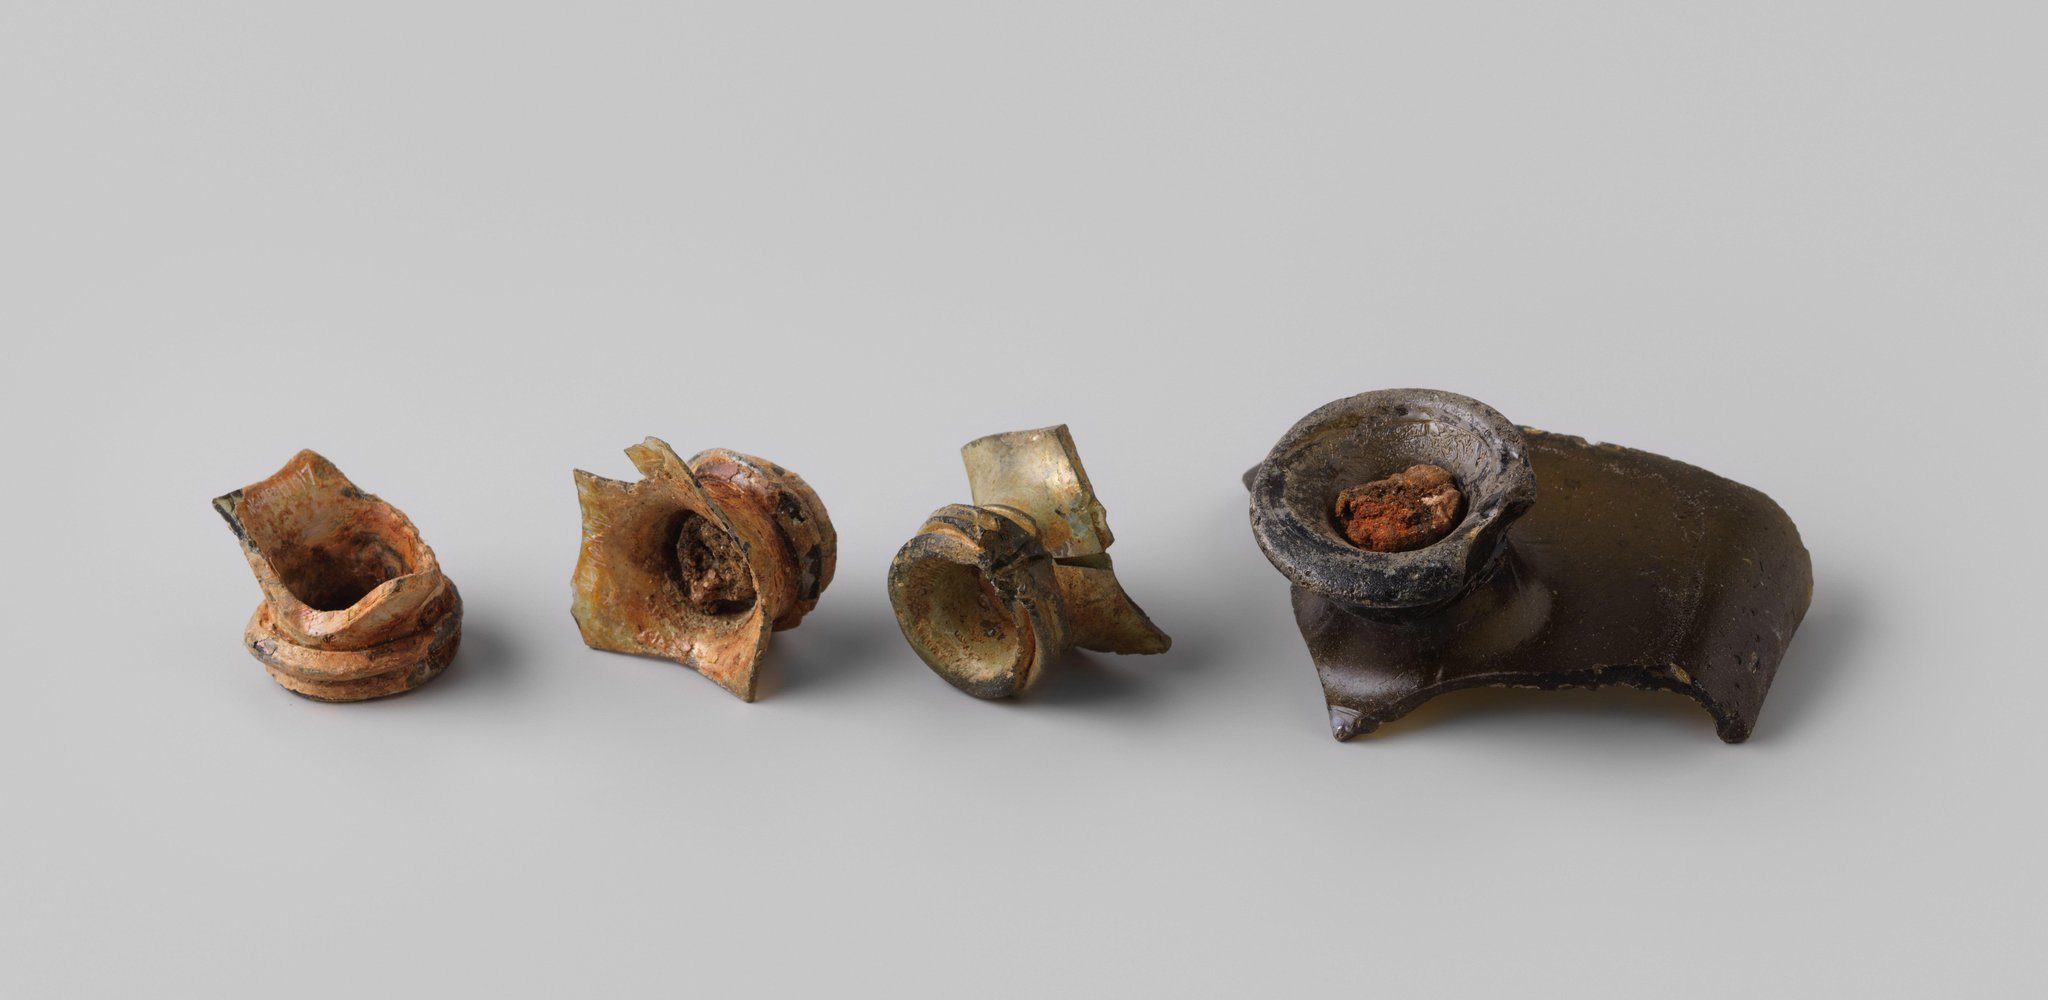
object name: case bottle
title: Halzen met kurk van kelderflessen uit het wrak van de Oost-Indiëvaarder Hollandia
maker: Anonymous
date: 1700-1743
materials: cork, glass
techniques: green glass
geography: netherlands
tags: verenigde oostindische compagnie, hollandia (schip), annet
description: Case bottle, fragm: necks, id. NG 1980-27H1286a; neck and shoulder fragm, wide everted mouth.